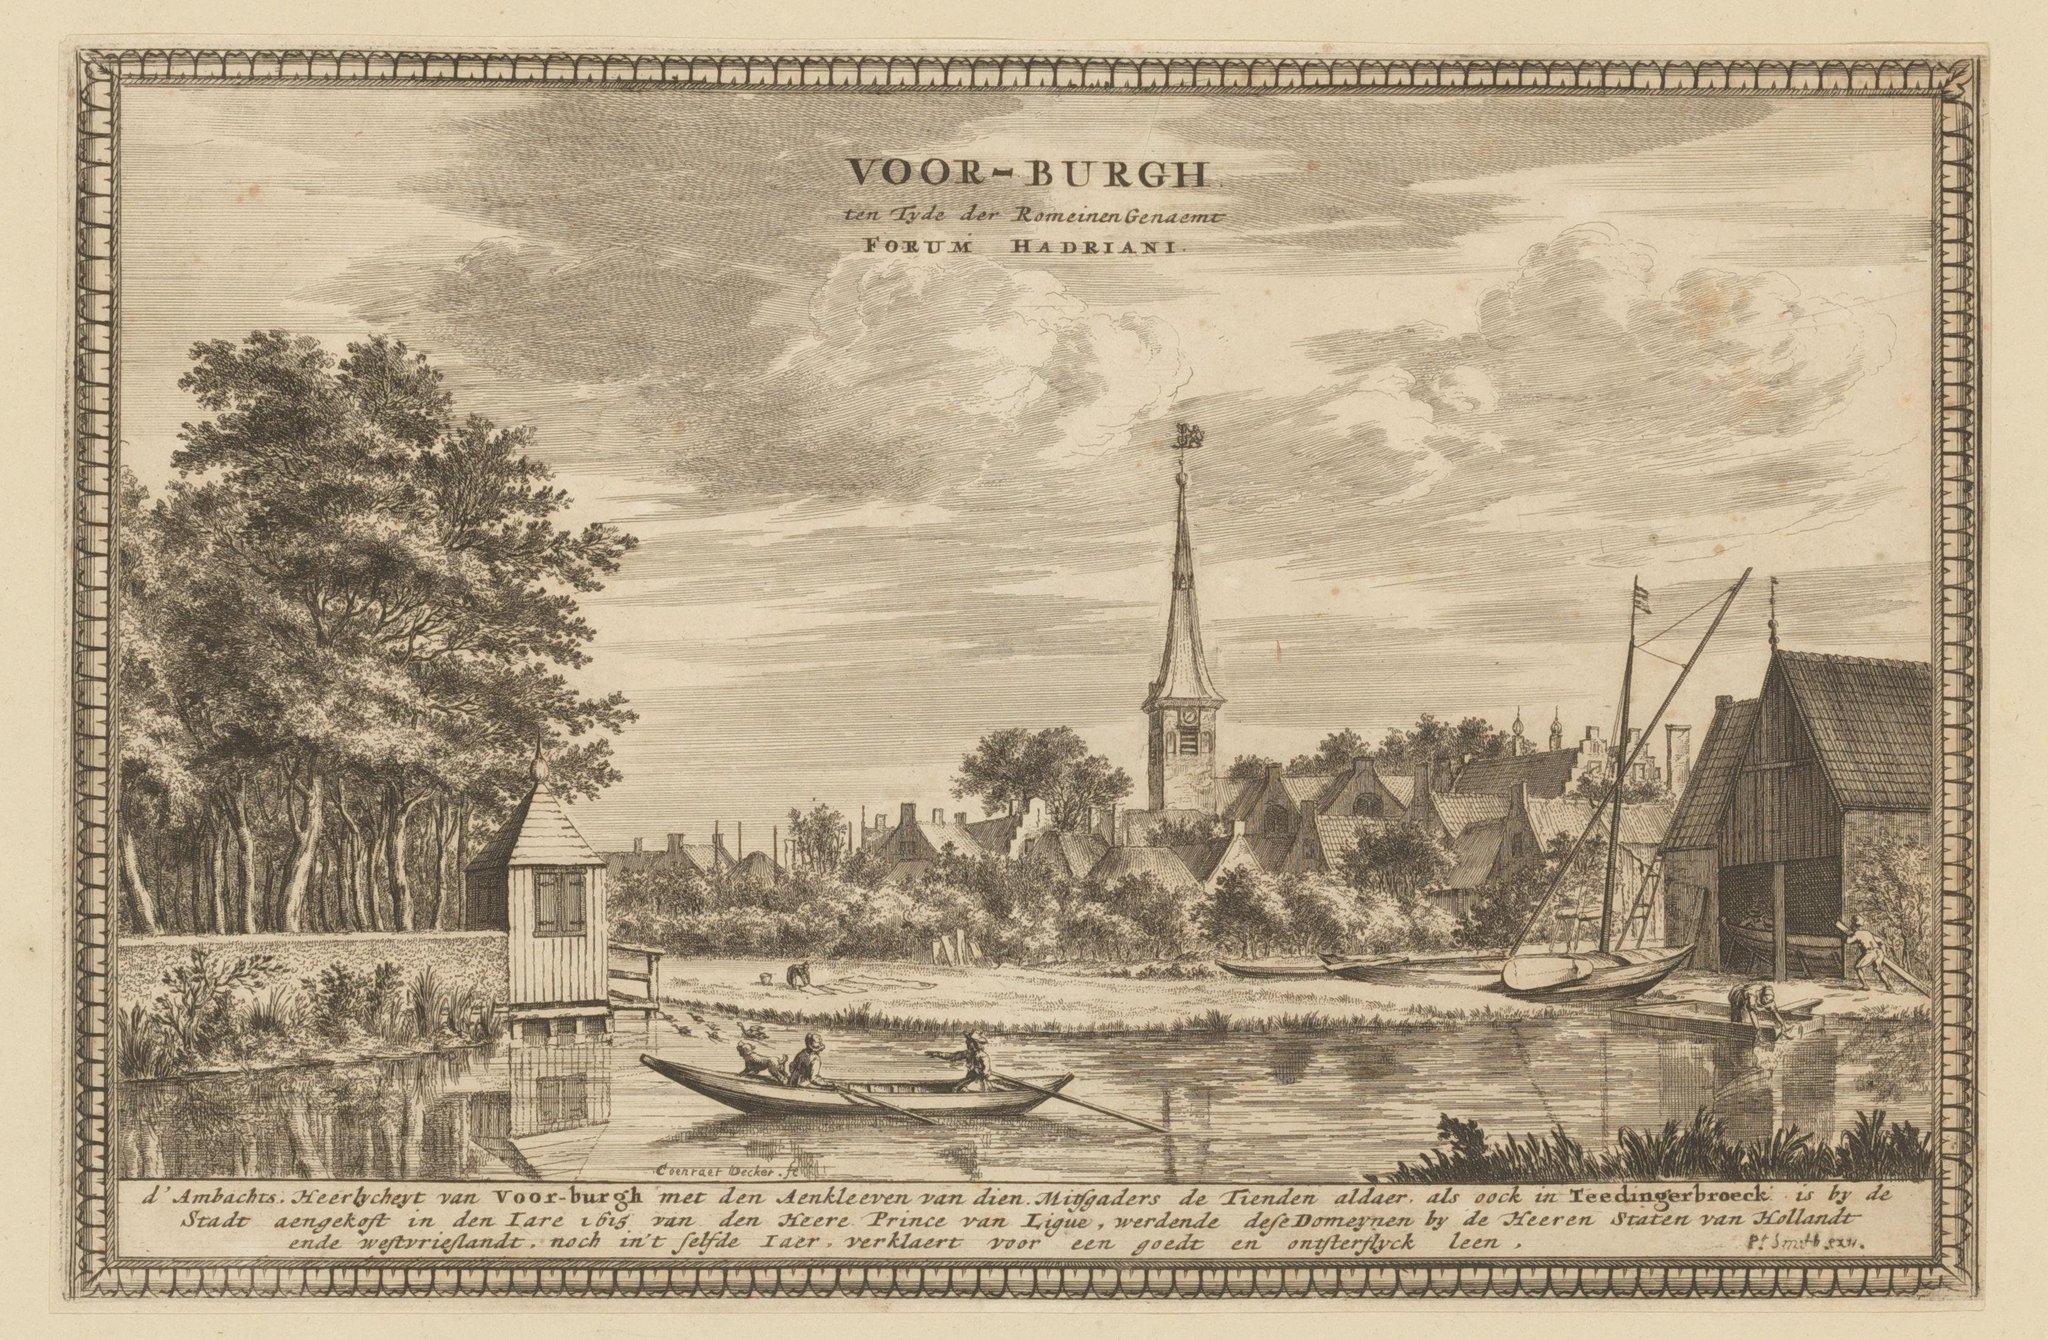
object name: print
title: Gezicht op Voorburg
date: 1678-1703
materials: paper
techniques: engraving, etching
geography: amsterdam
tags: prospect of village, silhouette of village, shipyard, shipdock, parts of church exterior and annexes: tower, voorburg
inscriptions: stamp, collector's mark: Lugt 1641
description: Deze prent is in 1678 voor het eerst uitgegeven als onderdeel van de rand van de zogenaamde Kaart Figuratief (Caerte figuratyff / Kaerte figuratyf) van Delft, een wandkaart van Delft. Deze kaart bestaat uit een plattegrond van Delft (RP-P-AO-11-8A) met daaromheen een rand. De rand bestaat uit een profiel van Delft (RP-P-AO-11-11), een profiel van Delfshaven met daaronder de wapenschilden van de burgemeesters van de stad (RP-P-AO-13-51-1 en RP-P-AO-13-51-2), 24 kleinere prenten (kaarten, afbeeldingen van gebouwen en graven van bekende personen, o.a. huidige prent, RP-P-AO-11-15, RP-P-AO-11-16, RP-P-AO-11-17, RP-P-AO-11-18, RP-P-AO-11-19, RP-P-AO-11-20, RP-P-AO-11-21, RP-P-AO-11-23, RP-P-AO-11-24, RP-P-AO-11-27, RP-P-AO-11-28, RP-P-AO-11-29, RP-P-AO-11-30, RP-P-AO-11-31, RP-P-AO-11-34, RP-P-AO-11-35, RP-P-AO-11-35-2, RP-P-AO-13-49, RP-P-AO-13-52, RP-P-AO-13-53, RP-P-AO-13-54-1 en RP-P-1909-6463) en een beschrijving van de stad (RP-P-AO-11-8E). De eerste druk van deze Kaart Figuratief (1678) werd, in opdracht van het Delftse stadsbestuur, verzorgd door Pieter Smith. In 1680 leverde Smith ook vijfhonderd afdrukken van de randprenten die bestemd waren voor Dirk Evertsz. Bleyswijcks 'Beschryvinge der stadt Delft' (1667) en het tweede deel: 'Vervolg van de beschryvinge der stadt Delft' (1680). In het tweede deel zat een bijlage waarin beschreven staat welke prenten waar in het eerste en tweede deel ingebonden dienden te worden. Een deel van de prenten was dus bestemd voor het in 1667 verschenen eerste deel en kon met het verschijnen van het tweede deel in 1680 alsnog worden ingebonden. Hierdoor wordt vaak gedacht dat de prenten uit het eerste deel dateren uit 1667, hetgeen niet klopt. De huidige prent is zodoende ook gebruikt in: Bleyswijck, Dirk Evertsz. Beschryvinge der stadt Delft, betreffende des selfs situatie, oorsprong en ouderdom, opkomst en voortgangh (…). Delft: Arnold Bon, 1667 (prenten vanaf 1680 ingebonden), p. 104. Pieter Mortier (I) verzorgde in 1703, tevens in opdracht van het stadsbestuur, een tweede uitgave van de Kaart Figuratief. Voor deze druk bracht graveur Thomas van der Wilt enkele aanpassingen aan op de platen van de plattegrond. De randplaten lijken, op de plaat met de wapens van de burgemeesters na, ongewijzigd te zijn gebleven. De plattegrond is in 1752, waarschijnlijk zonder de randprenten, opnieuw uitgegeven. Of de huidige prent is gebruikt als onderdeel van de rand van de Kaart Figuratief uit 1678 of 1703, of is gebruikt in 'Beschryvinge der stadt Delft' (1667, prenten 1680), is niet na te gaan.